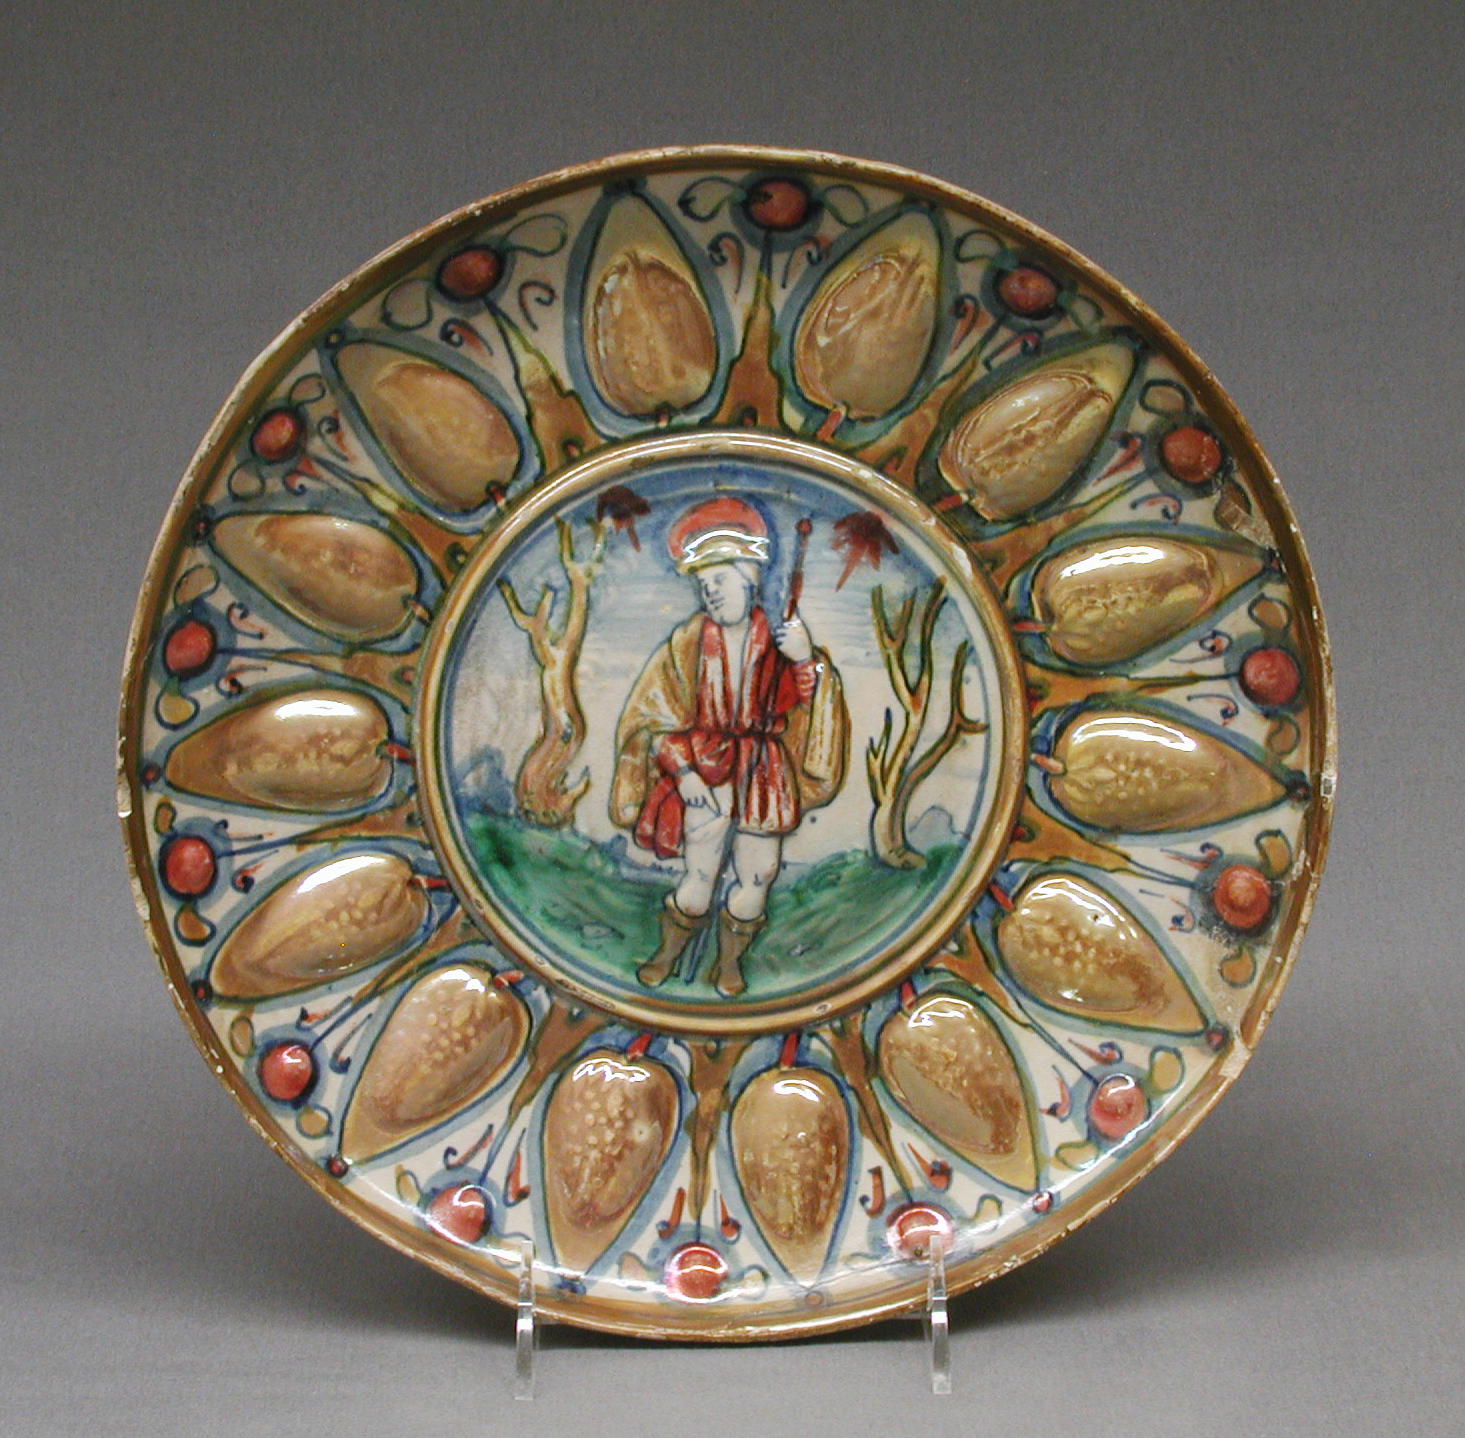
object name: dish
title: Dish with Saint Roche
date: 1535-1550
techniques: maiolica, glazing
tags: saints